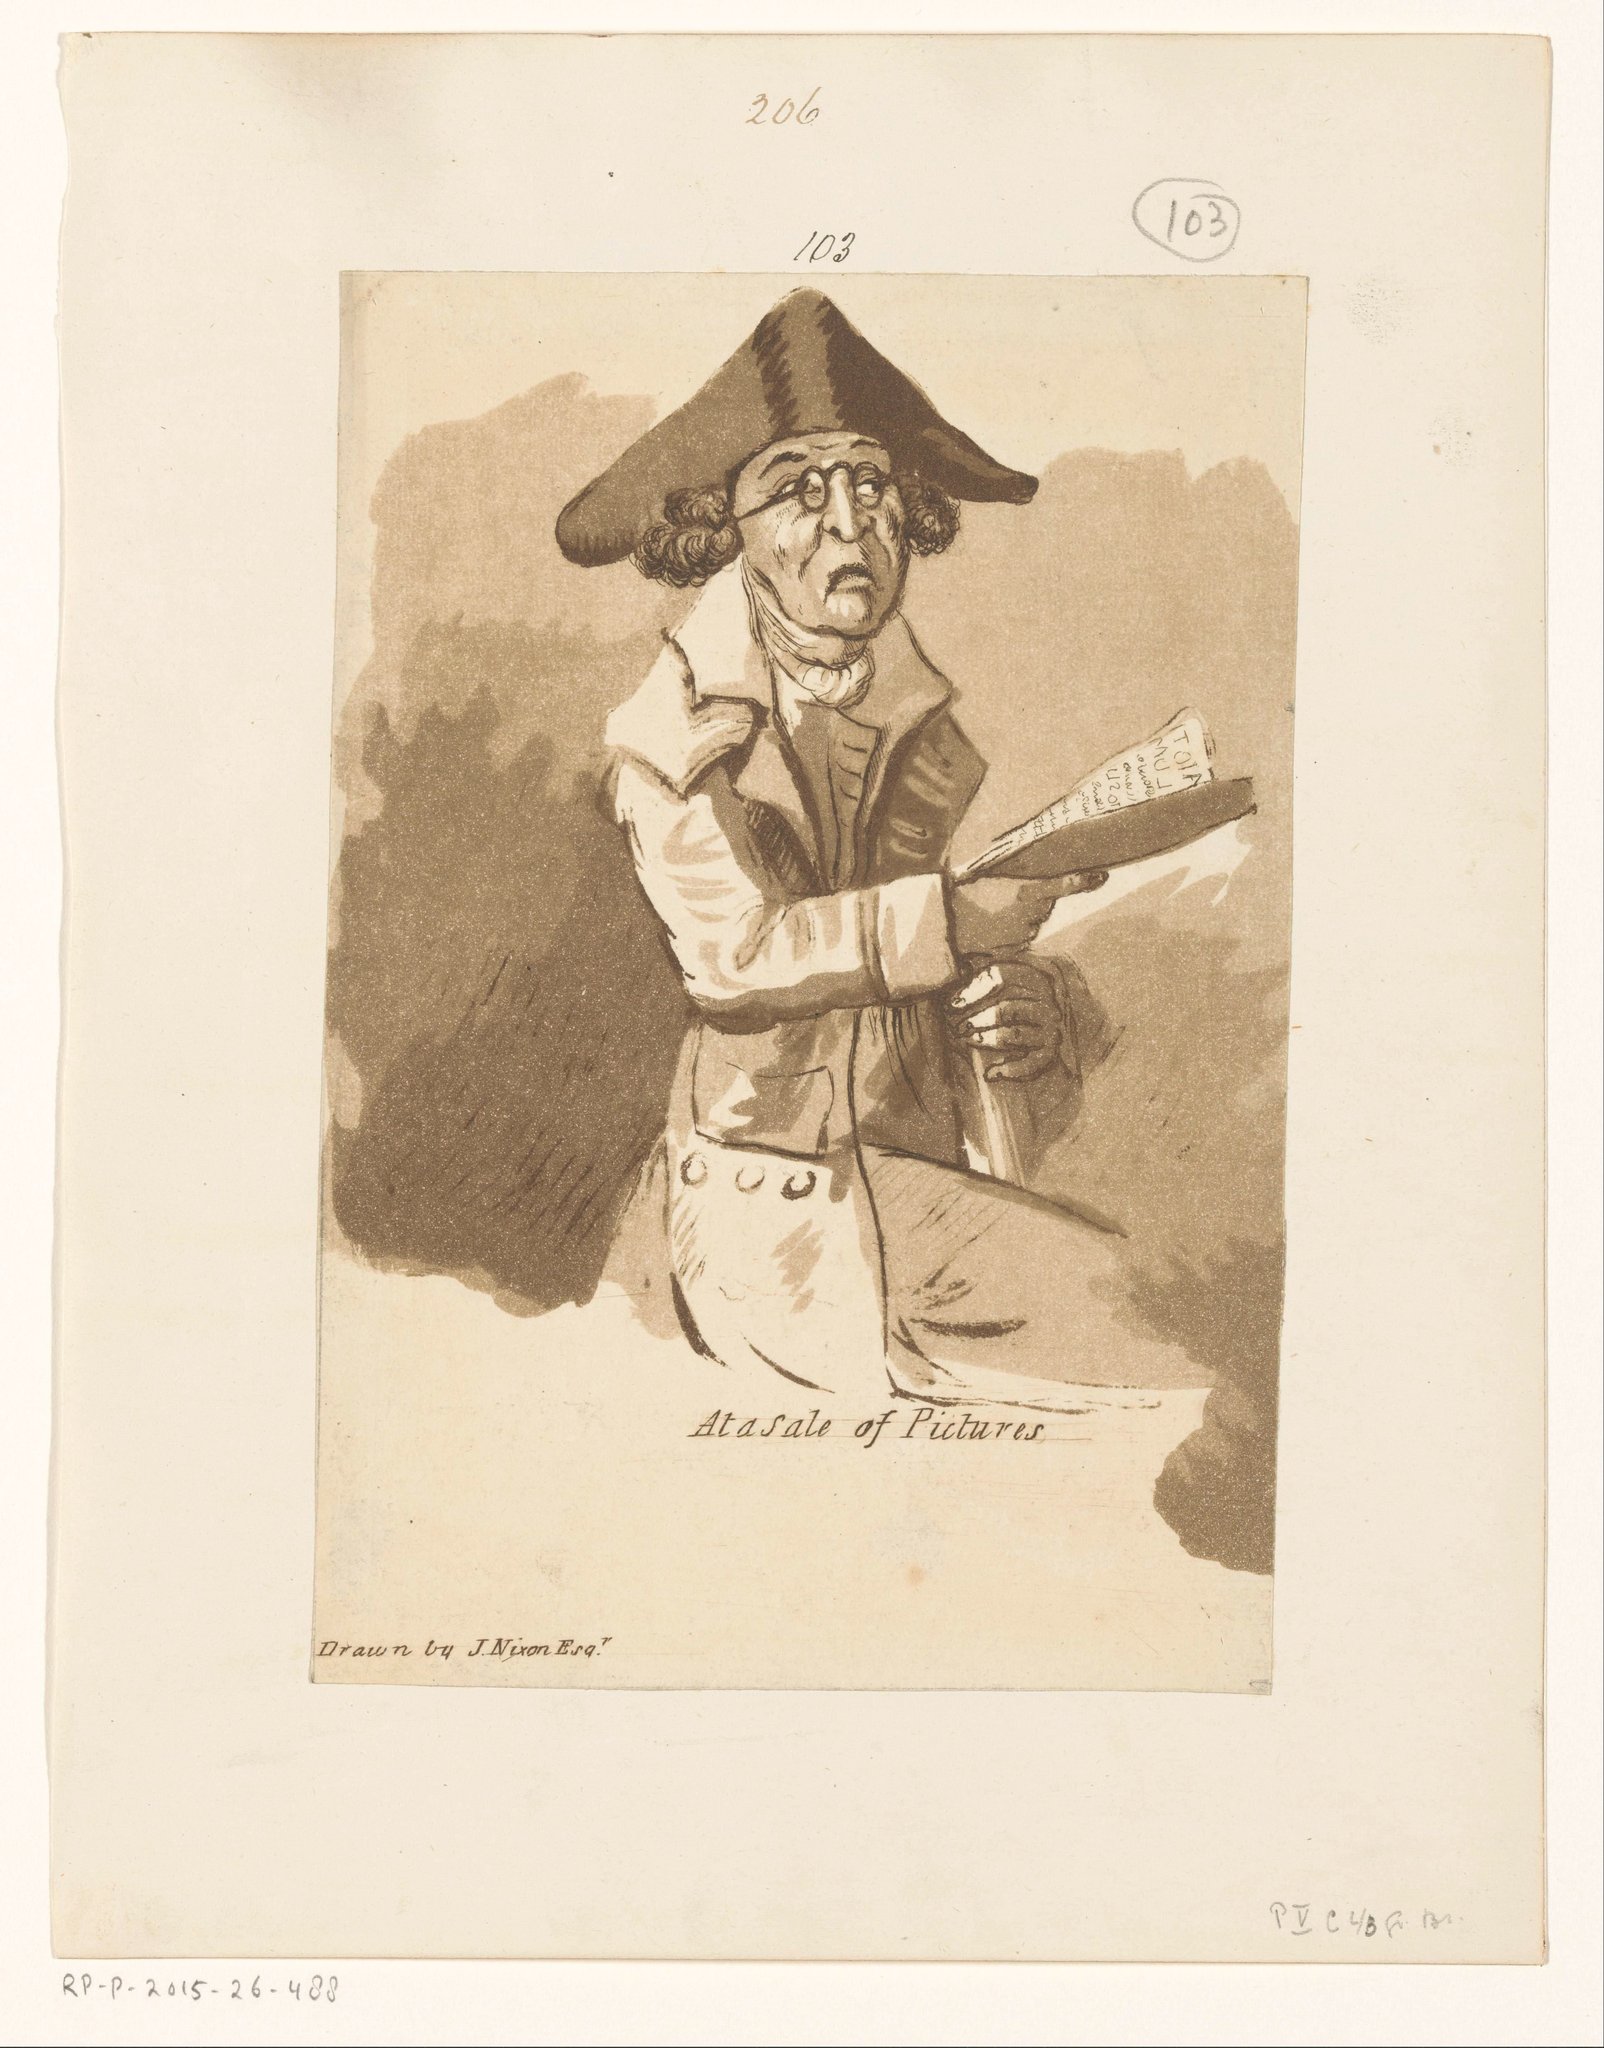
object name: print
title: At a sale of Pictures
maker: john nixon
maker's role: draughtsman, painter, print maker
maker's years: 1750-1818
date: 1792-1818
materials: paper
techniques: aquatint, etching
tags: head-gear: tricorn, art collecting, art sale, auction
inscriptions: collector's mark: Lugt 4779, number: ‘103/ 206’, collector's mark: Lugt 2228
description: Een man met een bril en een driehoekige hoed, een catalogus in zijn hand.